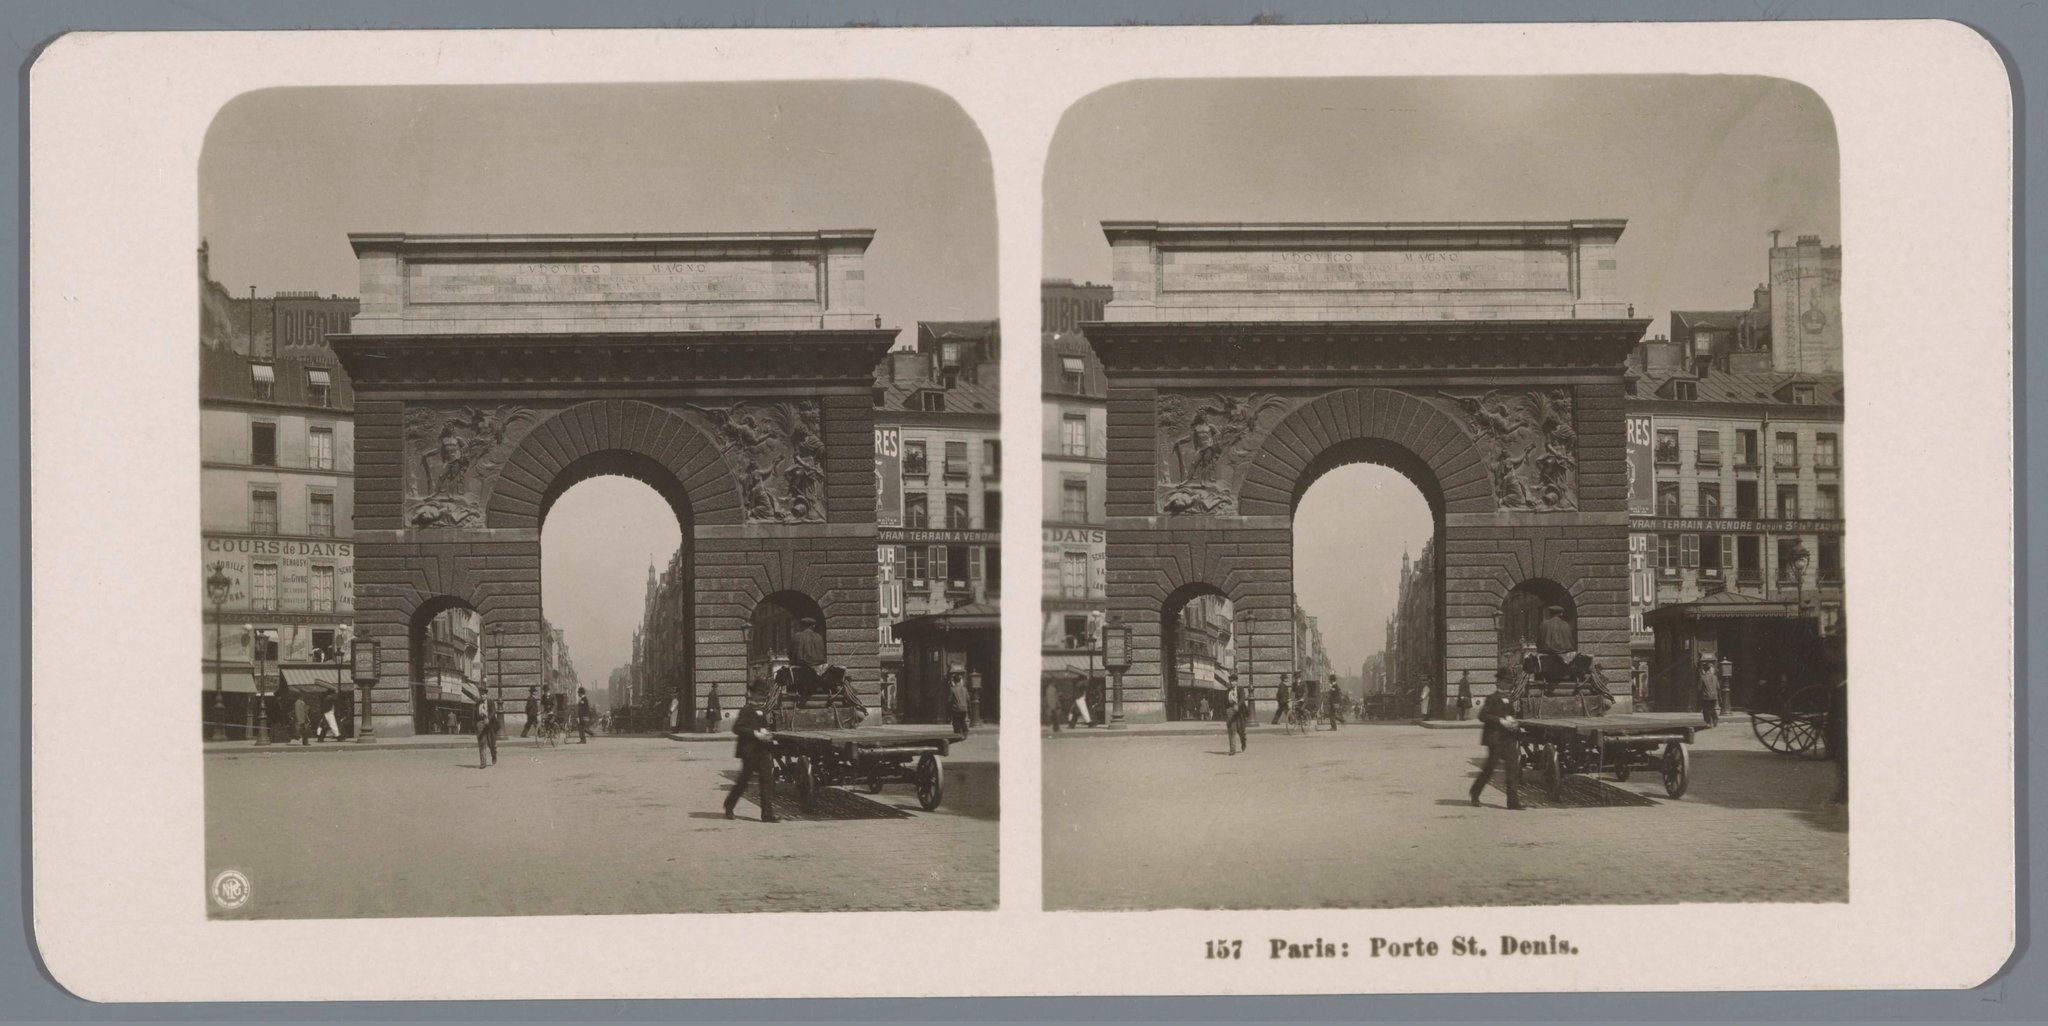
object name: stereograph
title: Paris: Porte St. Denis.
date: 1906-1915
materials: photographic support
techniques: gelatin silver print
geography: paris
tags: triumphal arch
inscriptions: annotation: ‘NPG’, number: ‘157’